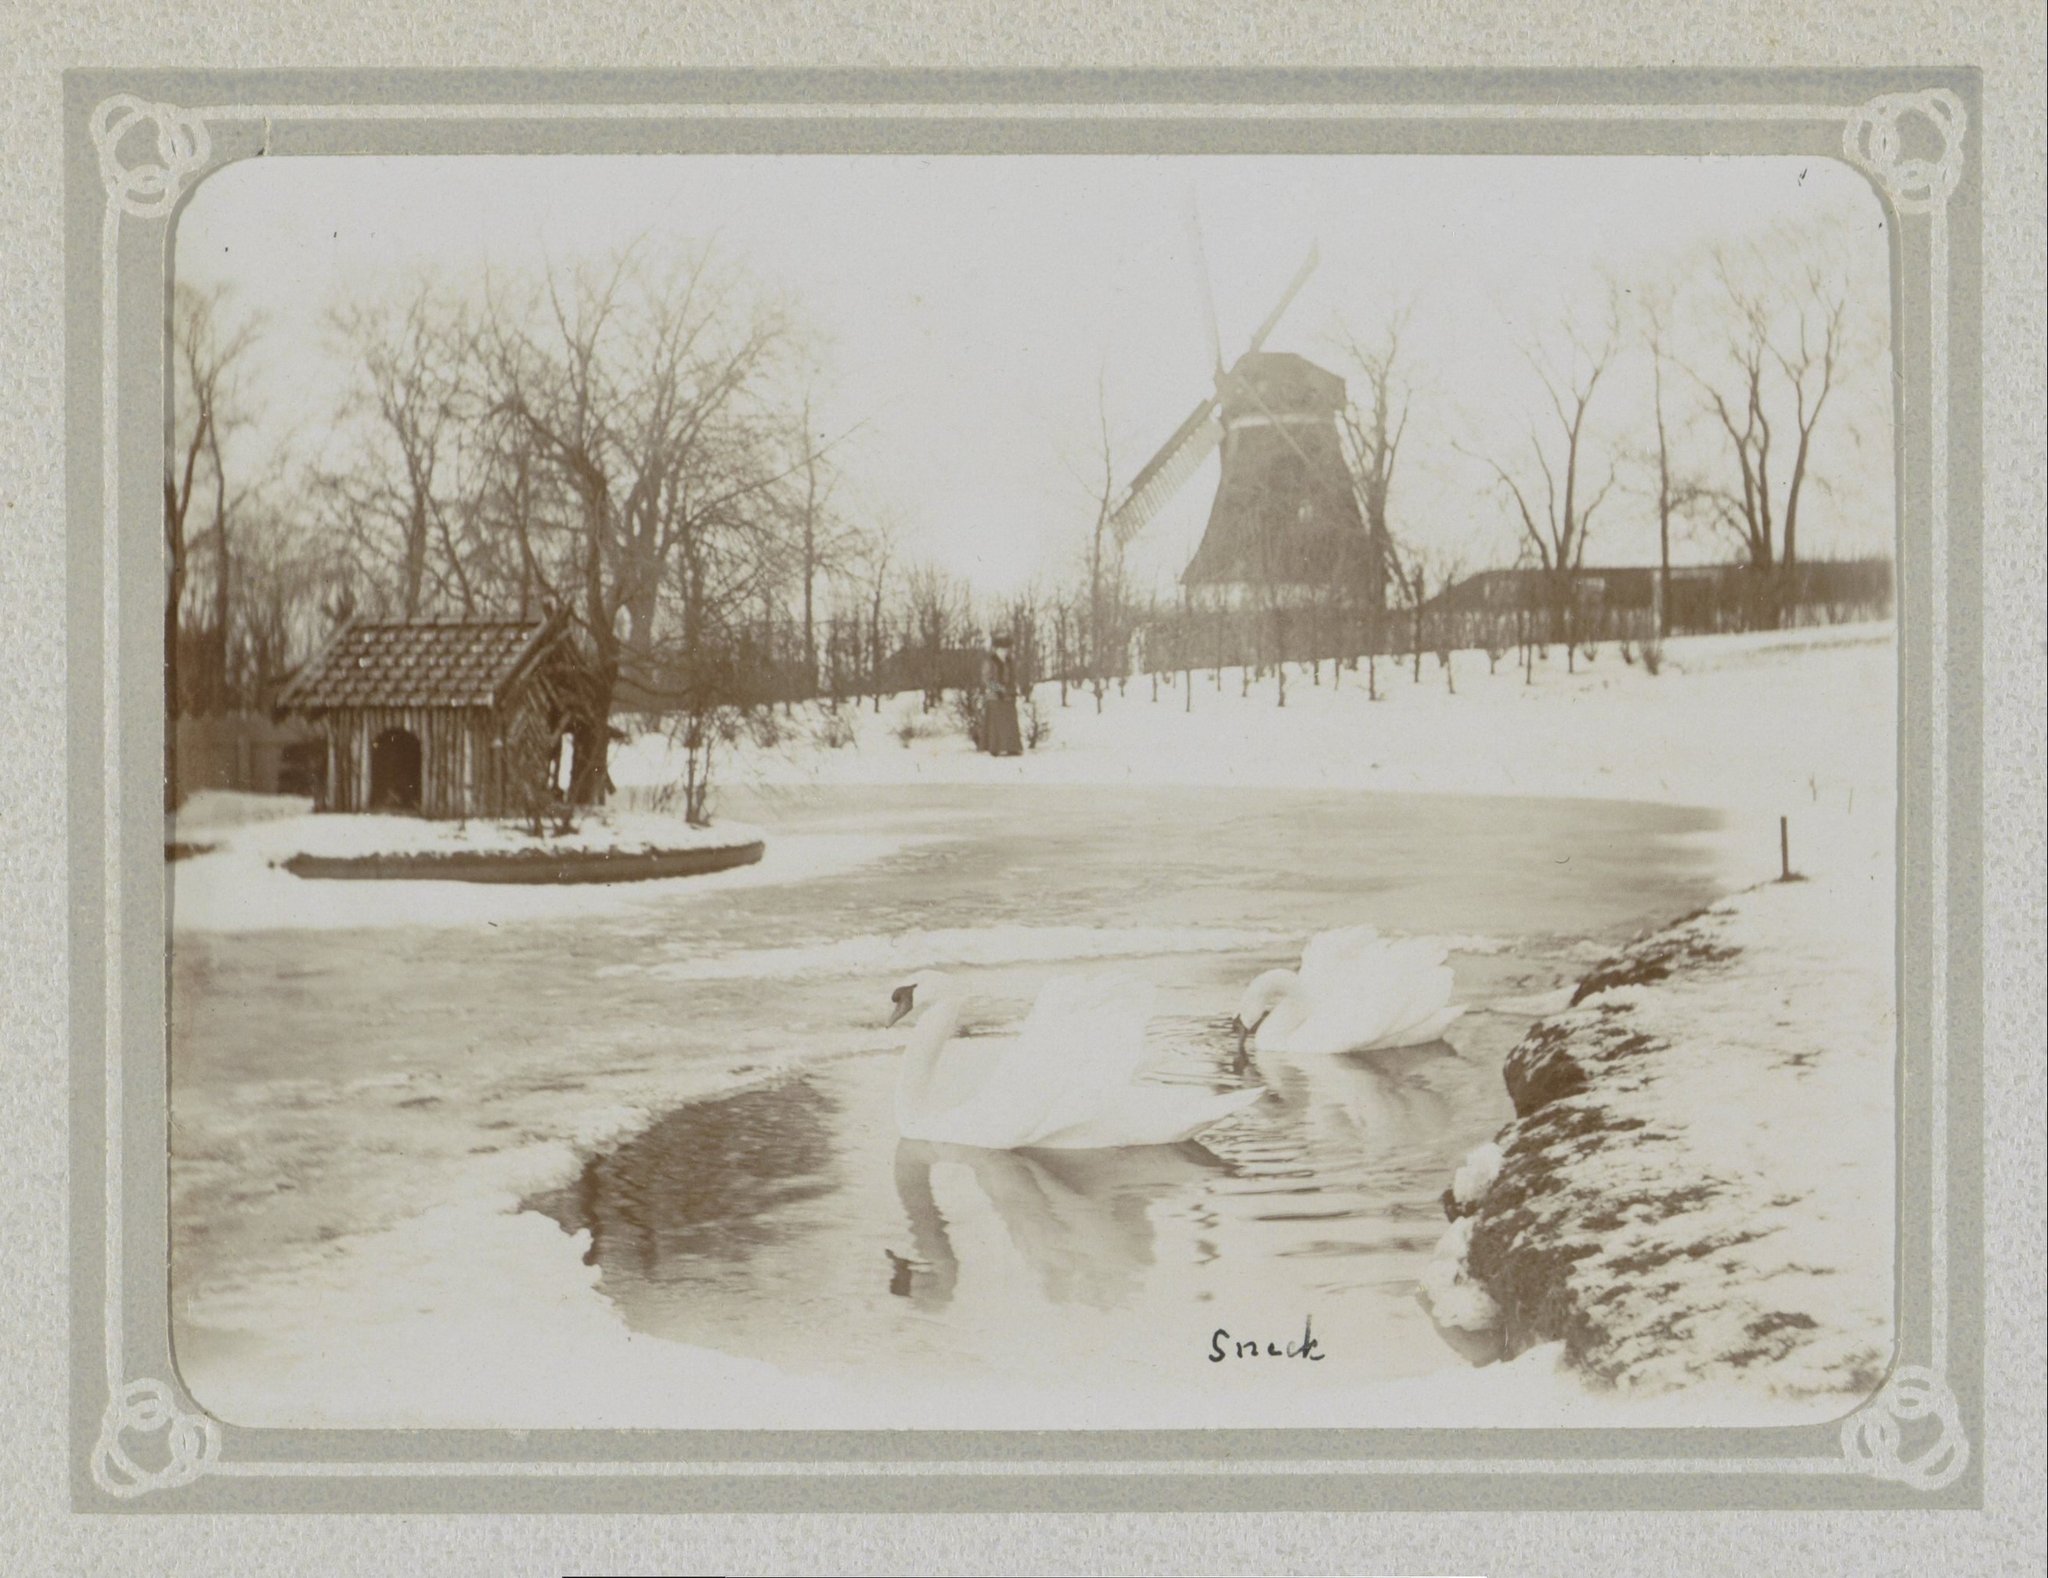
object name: photograph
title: Sneek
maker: folkert idzes de jong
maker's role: architect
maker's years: 1877-1929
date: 1905-1907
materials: photographic support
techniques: collodion silver print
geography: sneek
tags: water-birds: swan, winter landscape; landscape symbolizing winter (the four seasons of the year), windmill in landscape, snow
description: Onderdeel van Topografisch album van Nederlandse dorpen en steden 1905.